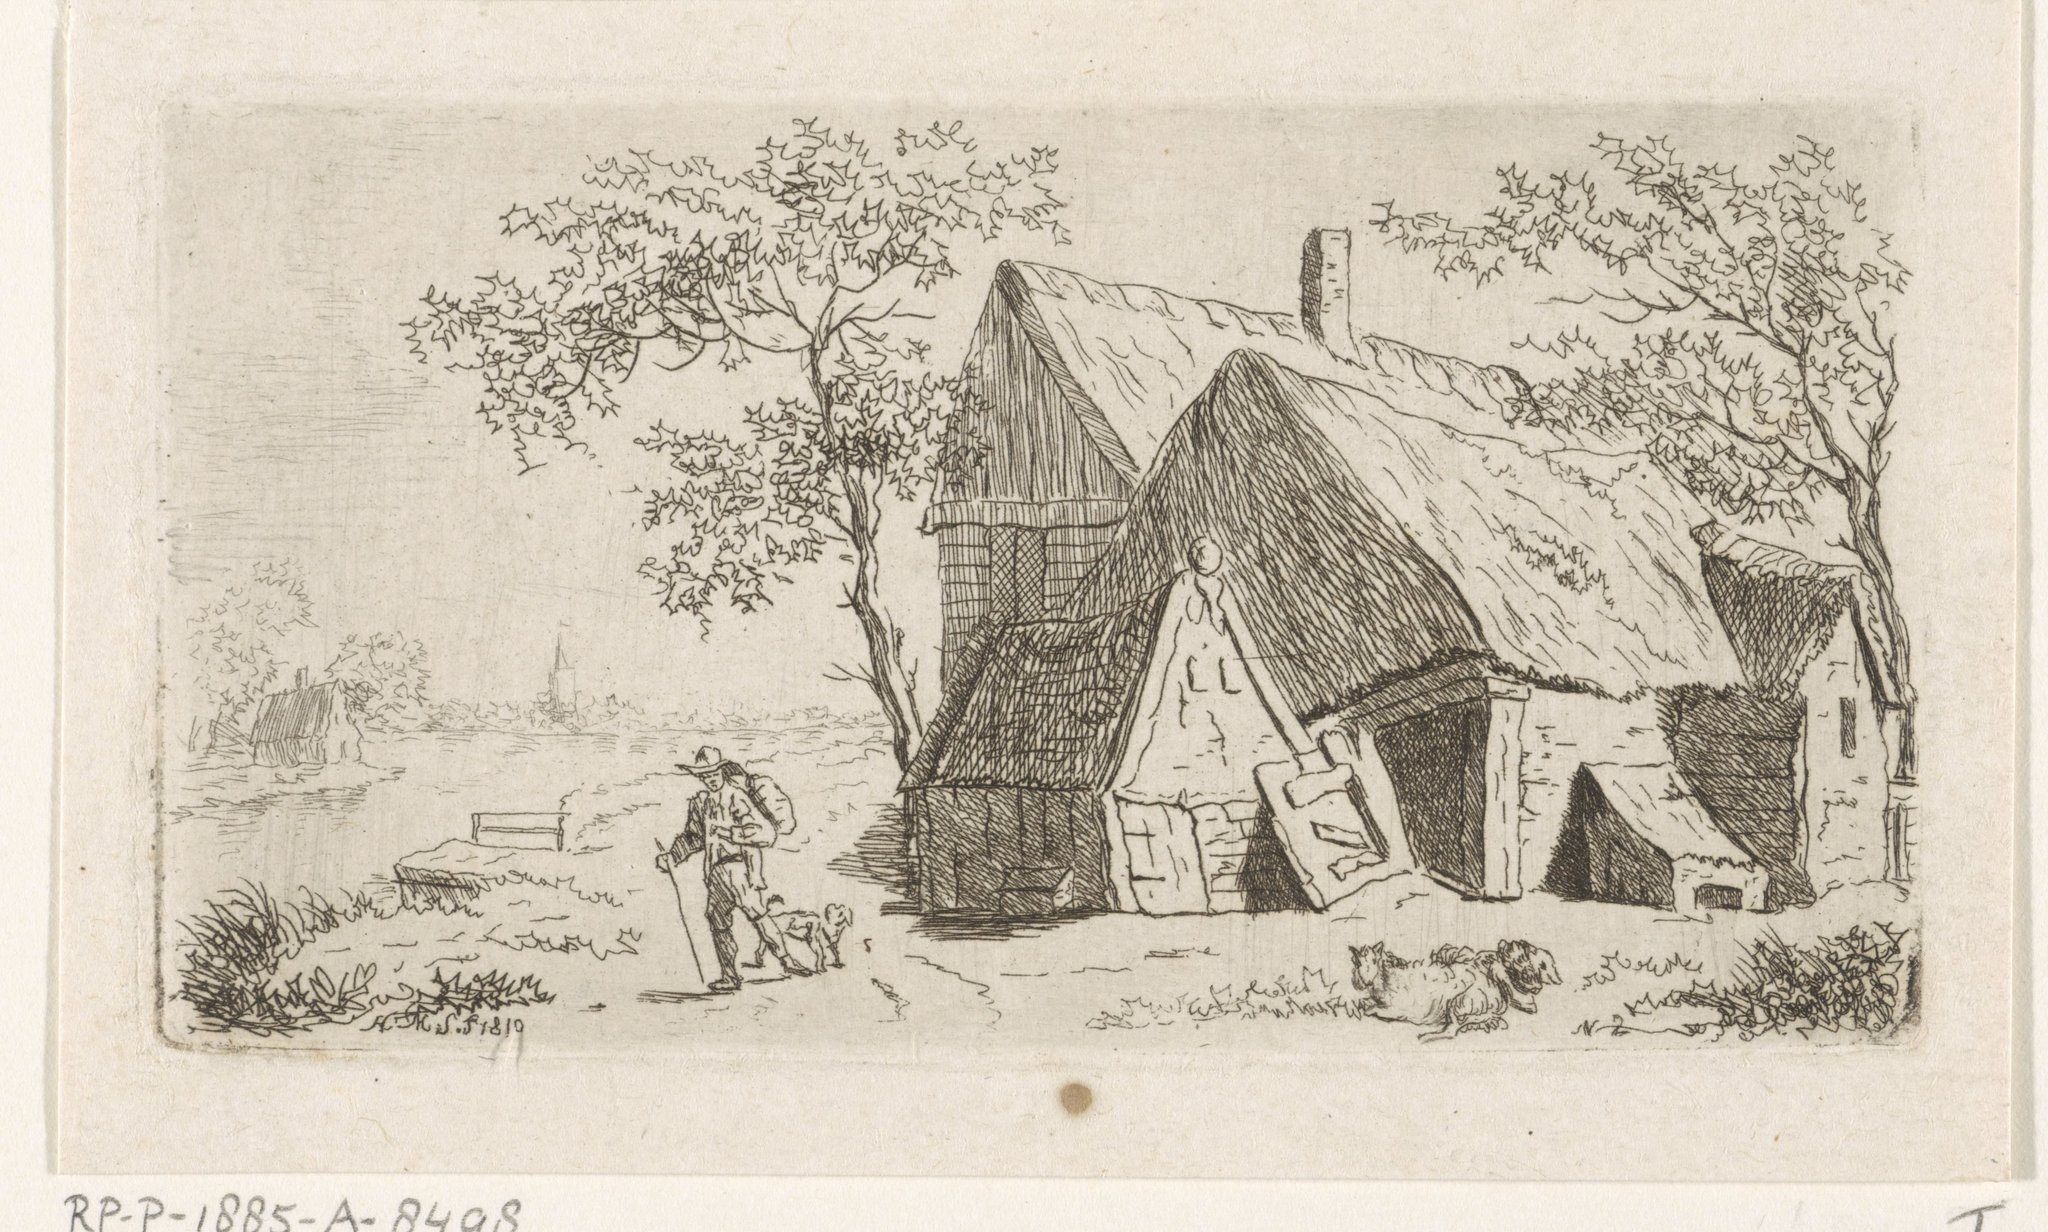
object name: print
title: Man met hond bij een boerderij aan het water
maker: hendrik marcus schouten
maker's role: print maker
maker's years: 1791-1835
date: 1810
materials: paper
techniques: etching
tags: farm or solitary house in landscape, dog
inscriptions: collector's mark: Lugt 2228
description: De man en de hond, bij de boerenwoning. Prent beschreven op A 5367. Minder bewerkte staat. De schaduw van 't huis naar den waterkant links is nog niet geëtst.